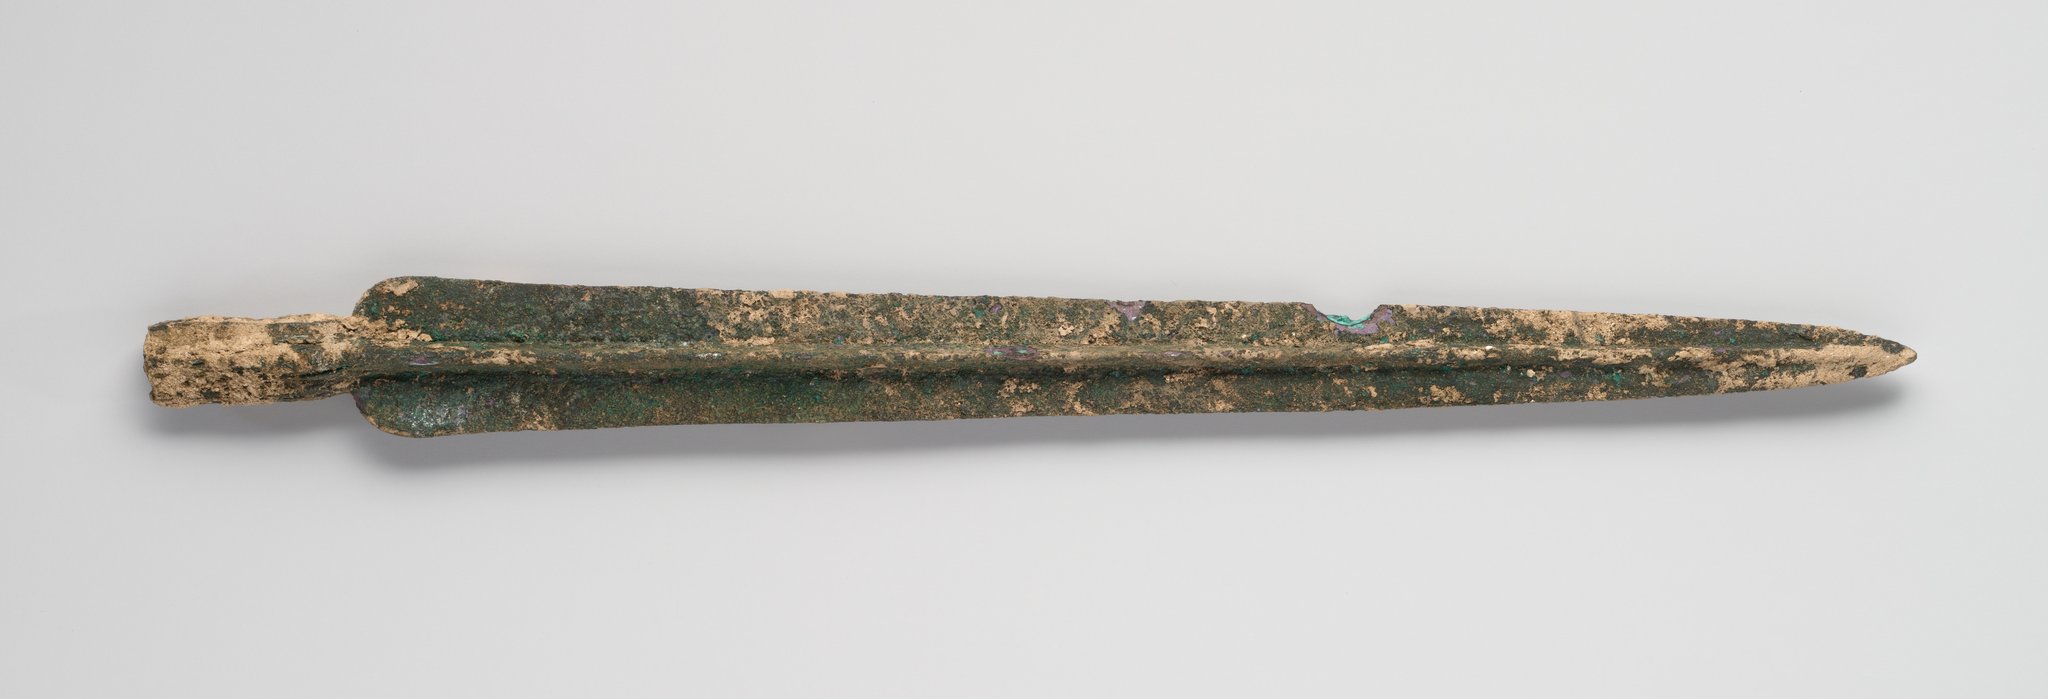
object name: spearhead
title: Bronze spearhead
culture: cypriot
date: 1200-1101 BCE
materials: bronze